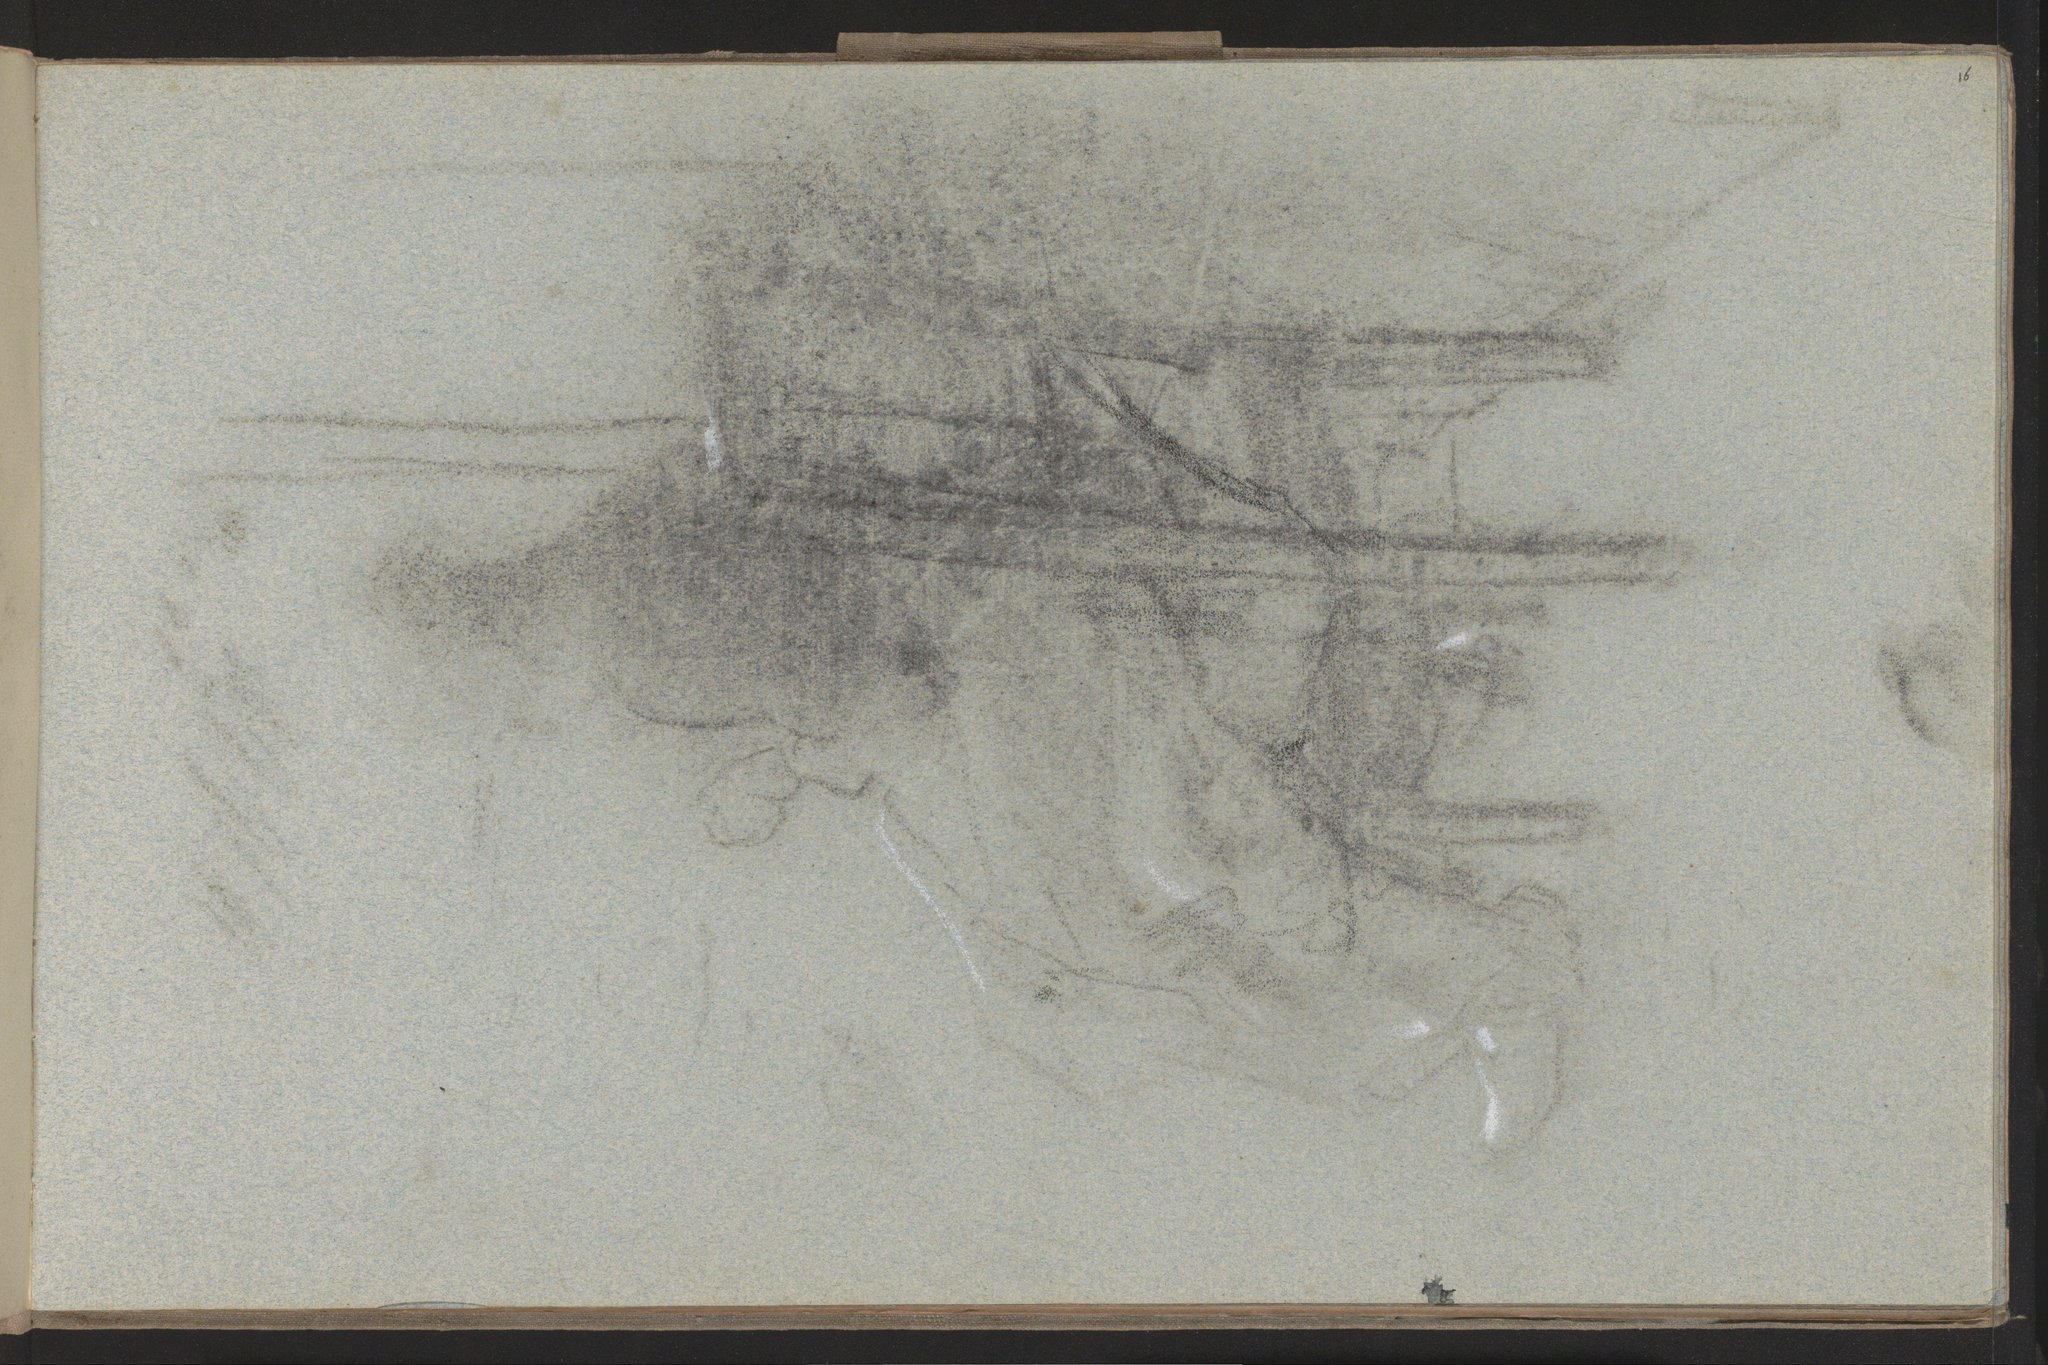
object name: sketchbook leaf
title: Handwerkende boerenvrouw zittend op een houten stoel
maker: albert neuhuys (1844-1914)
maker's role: draughtsman, painter, print maker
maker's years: 1844-1914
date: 1854-1914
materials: charcoal, paint, paper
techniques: brush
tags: sitting figure, adult woman, wooden shoes, clogs, interior of the house, sewing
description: Blad 16 recto uit een schetsboek met 51 bladen.